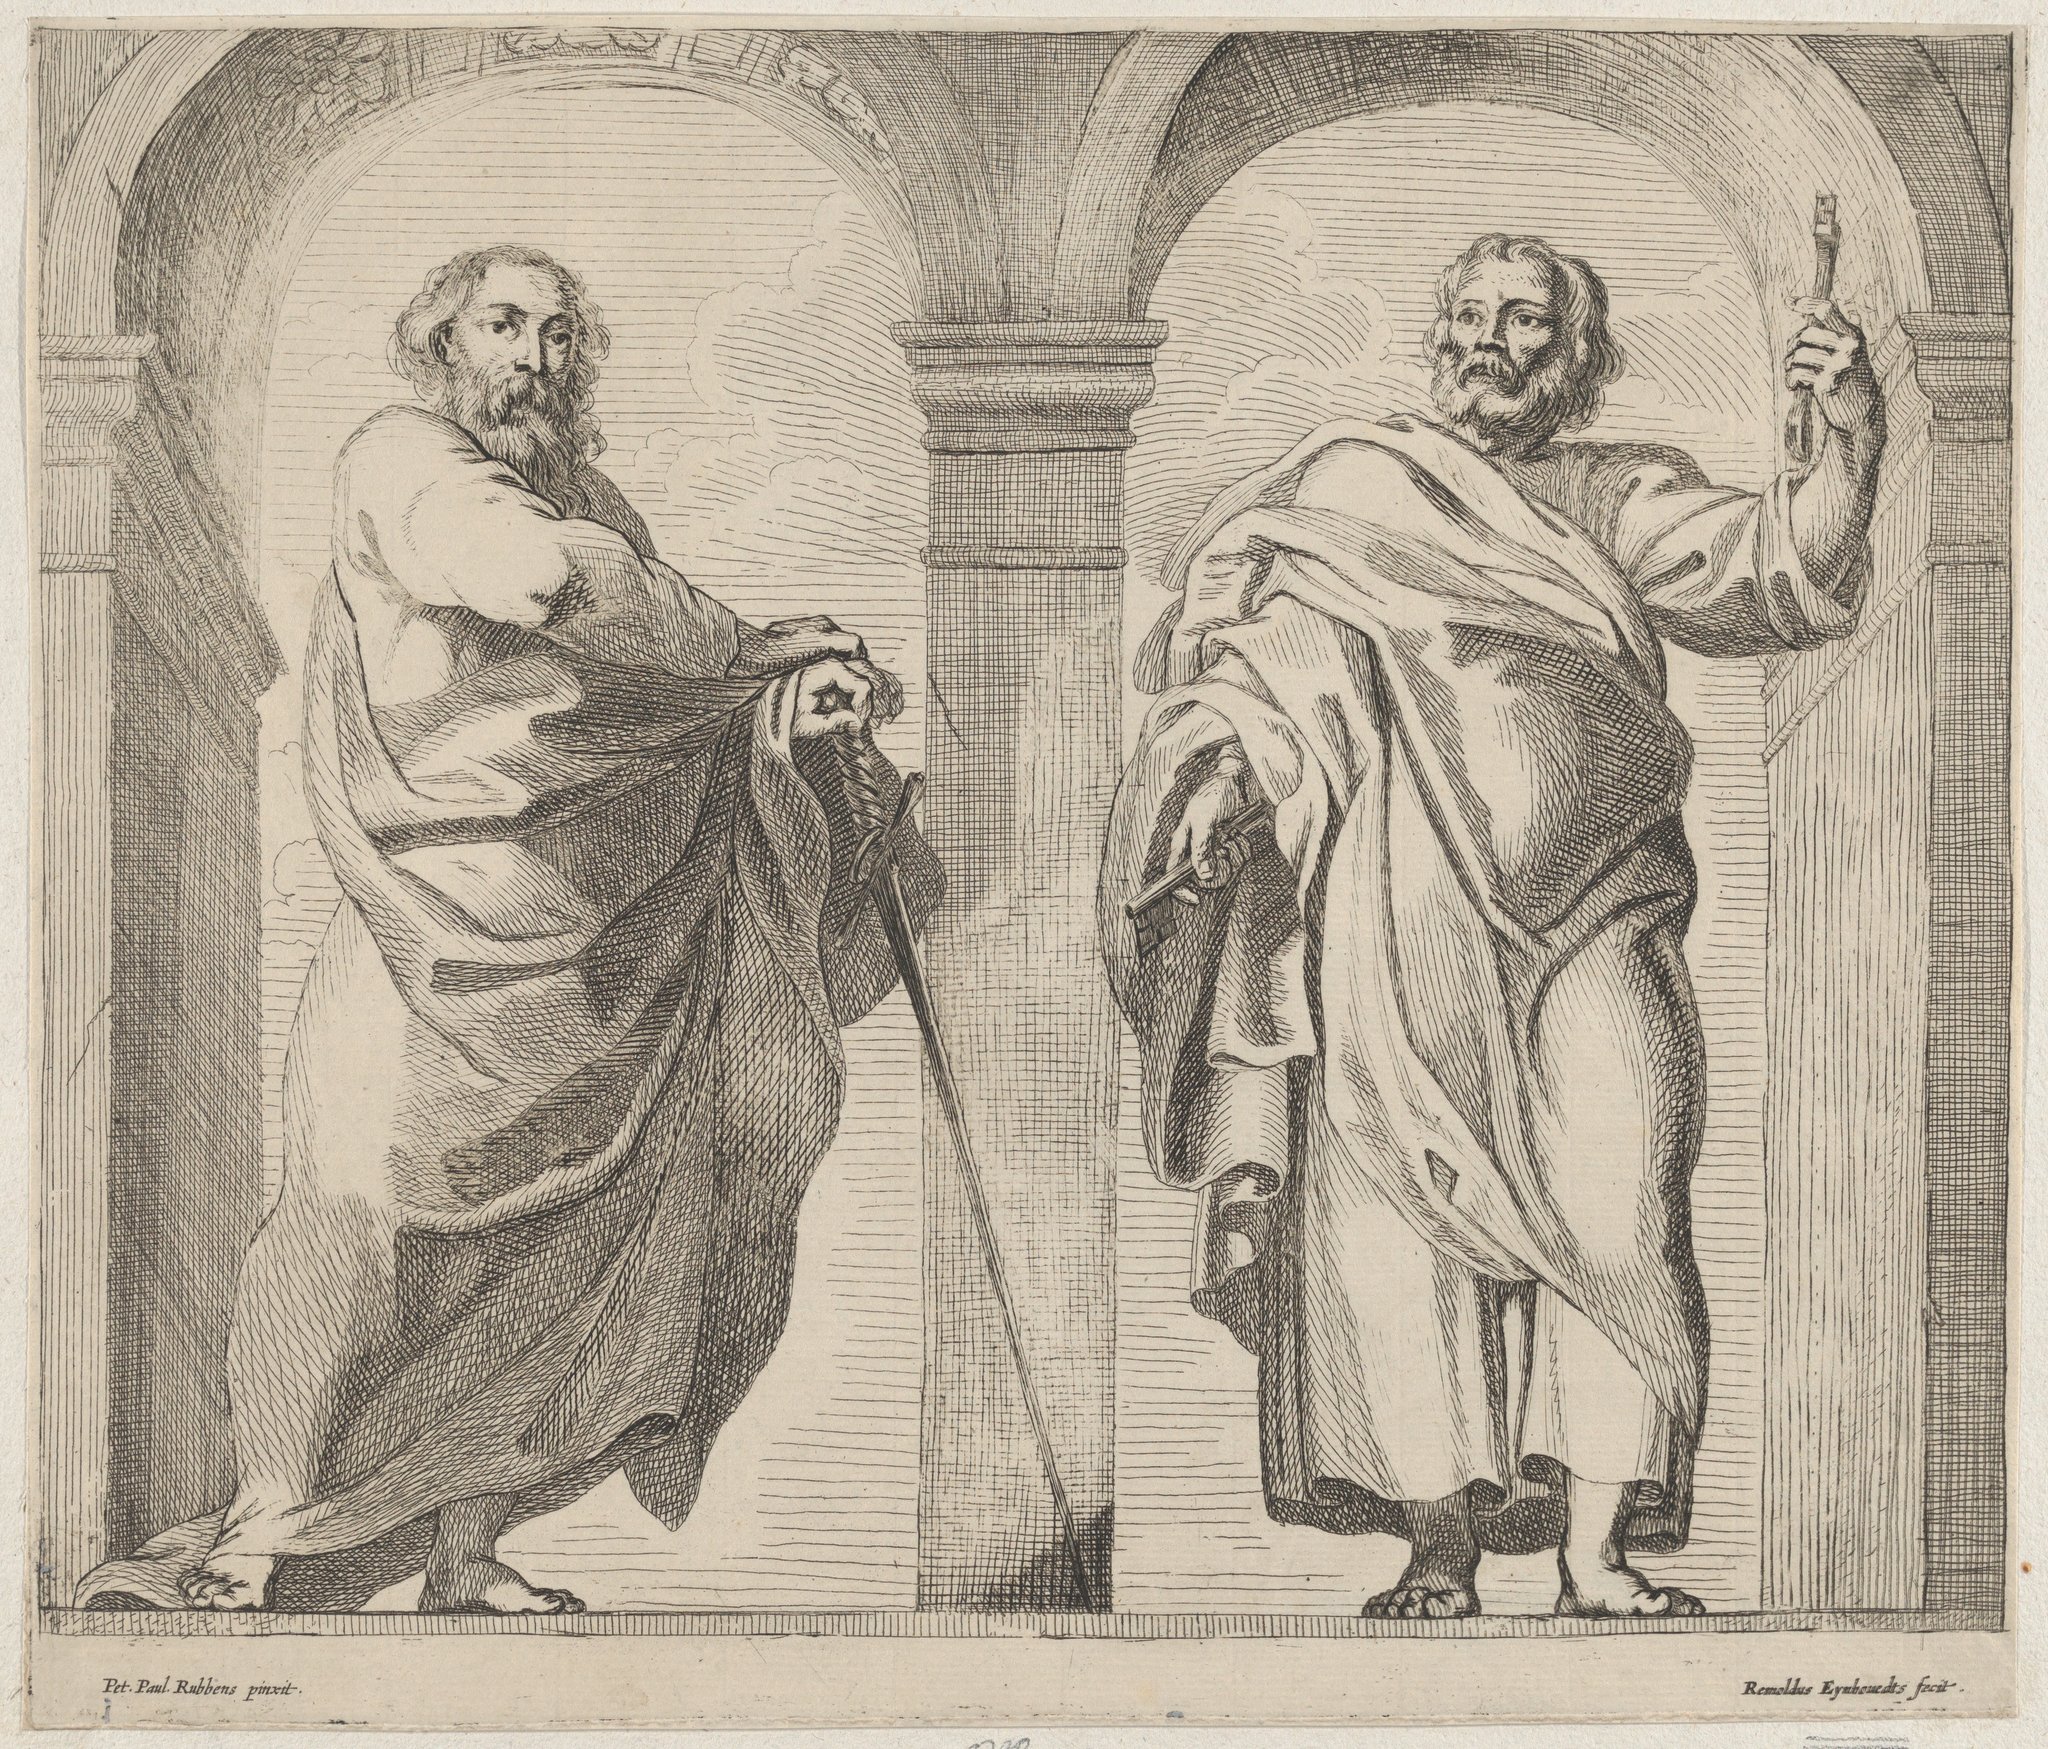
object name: print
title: Saints Peter and Paul in a vestibule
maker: rombout eynhoudts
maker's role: artist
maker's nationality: dutch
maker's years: 1613-1680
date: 1630-1680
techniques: etching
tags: saint paul,saint peter